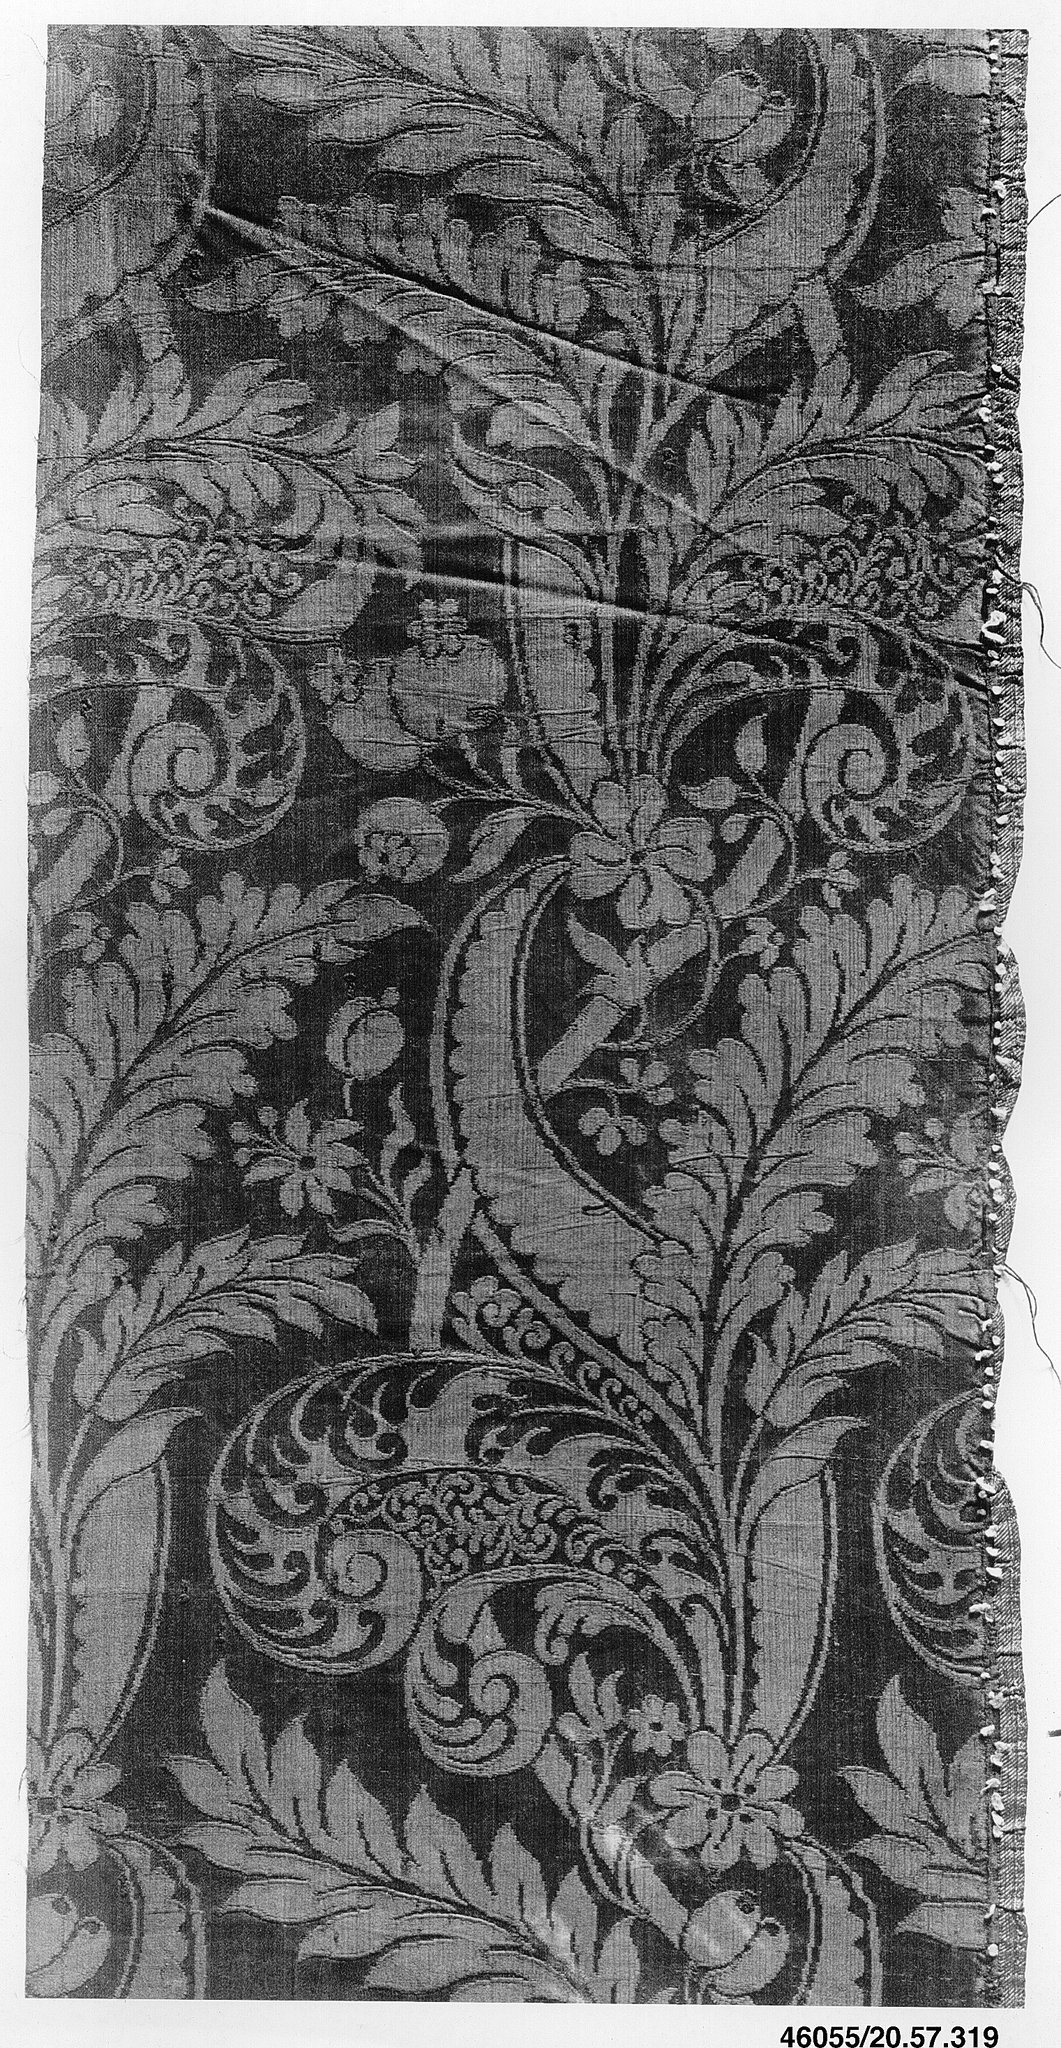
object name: piece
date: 1715-1720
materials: silk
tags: flowers,leaves